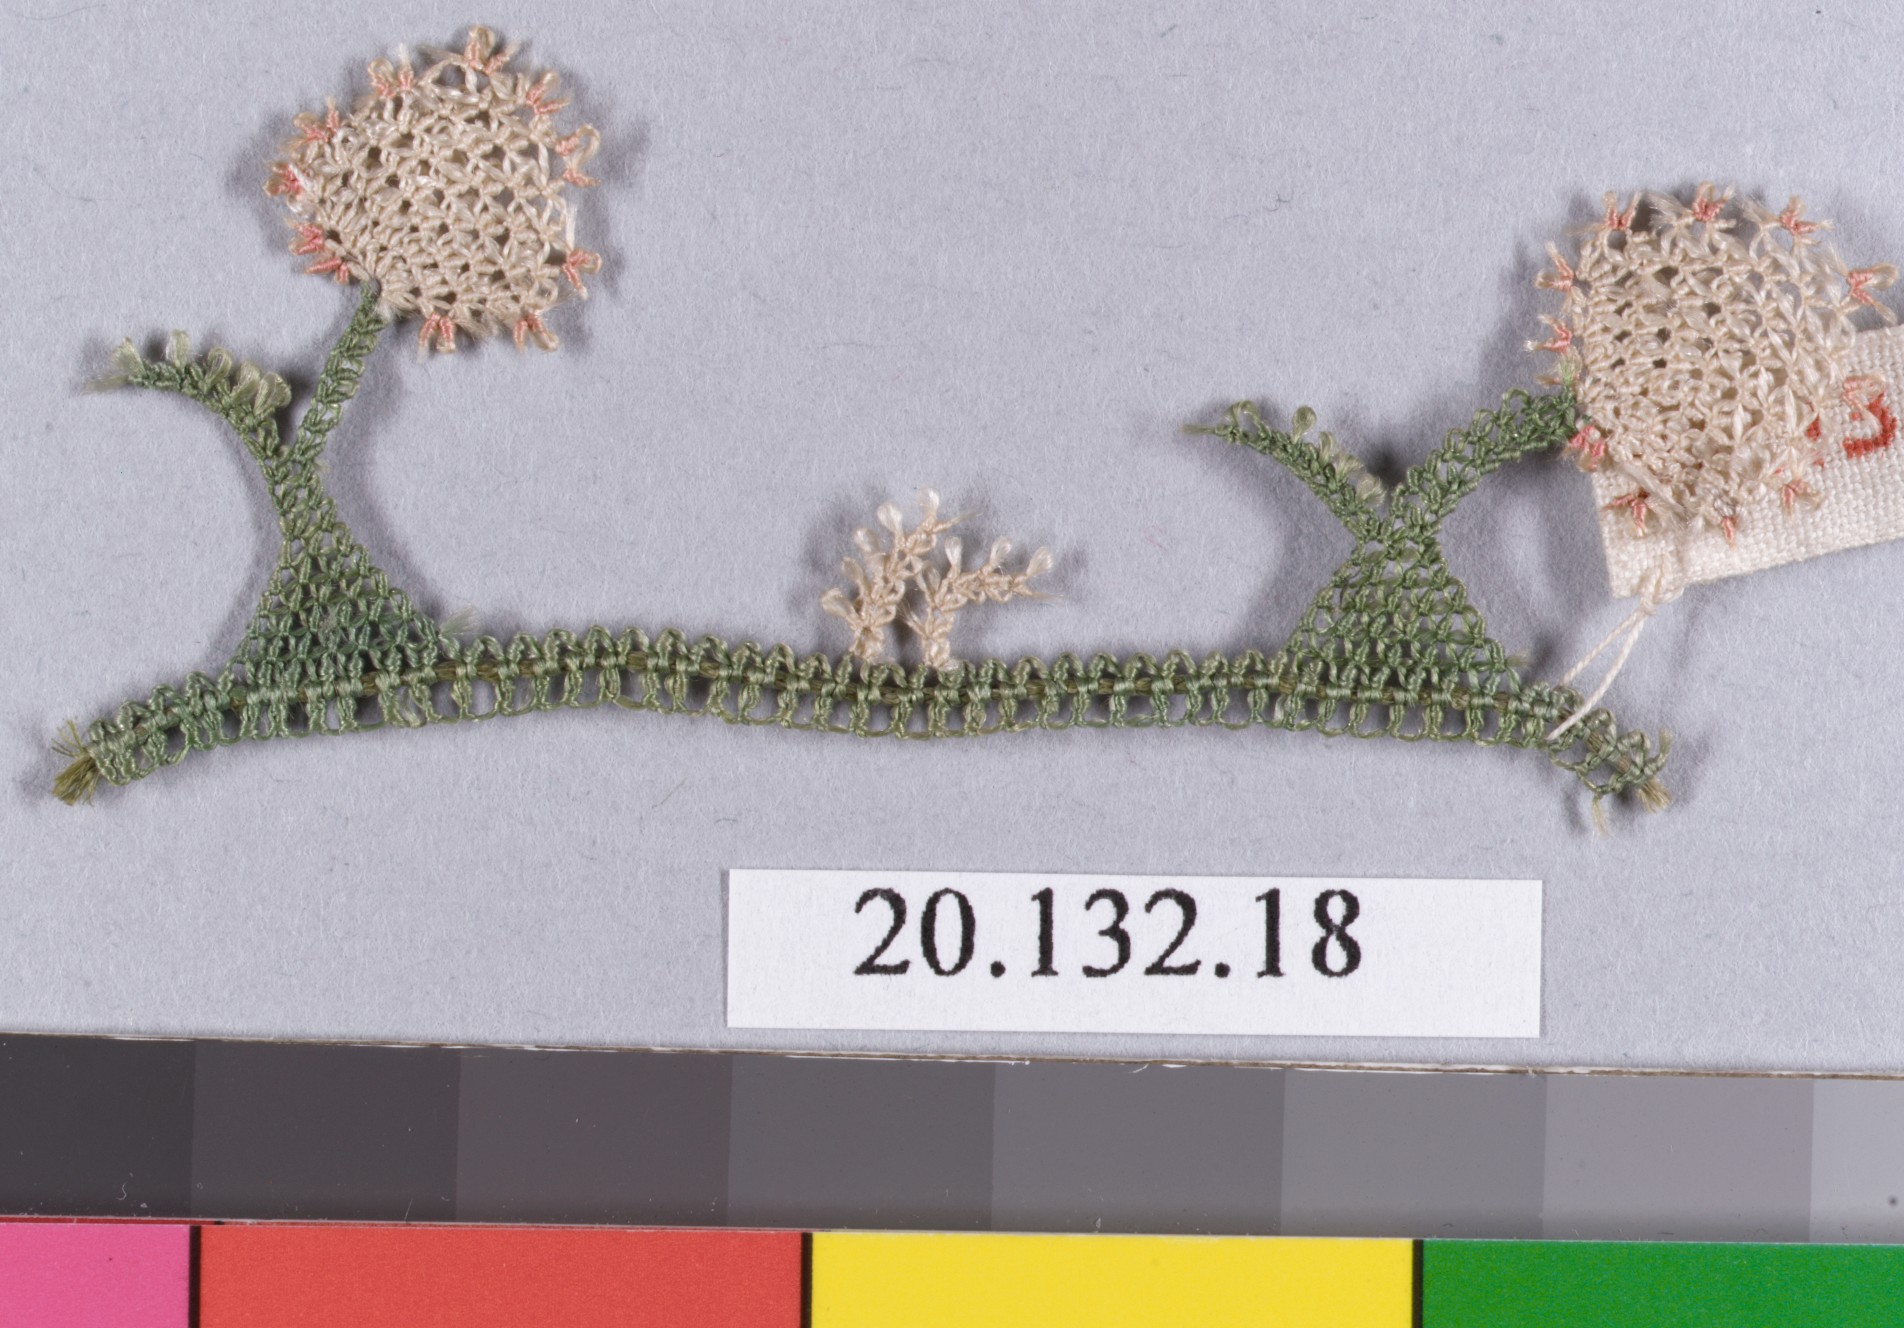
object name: oyah bibilia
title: Oyah (Bibilia)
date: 1801-1900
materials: silk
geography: turkey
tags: trees